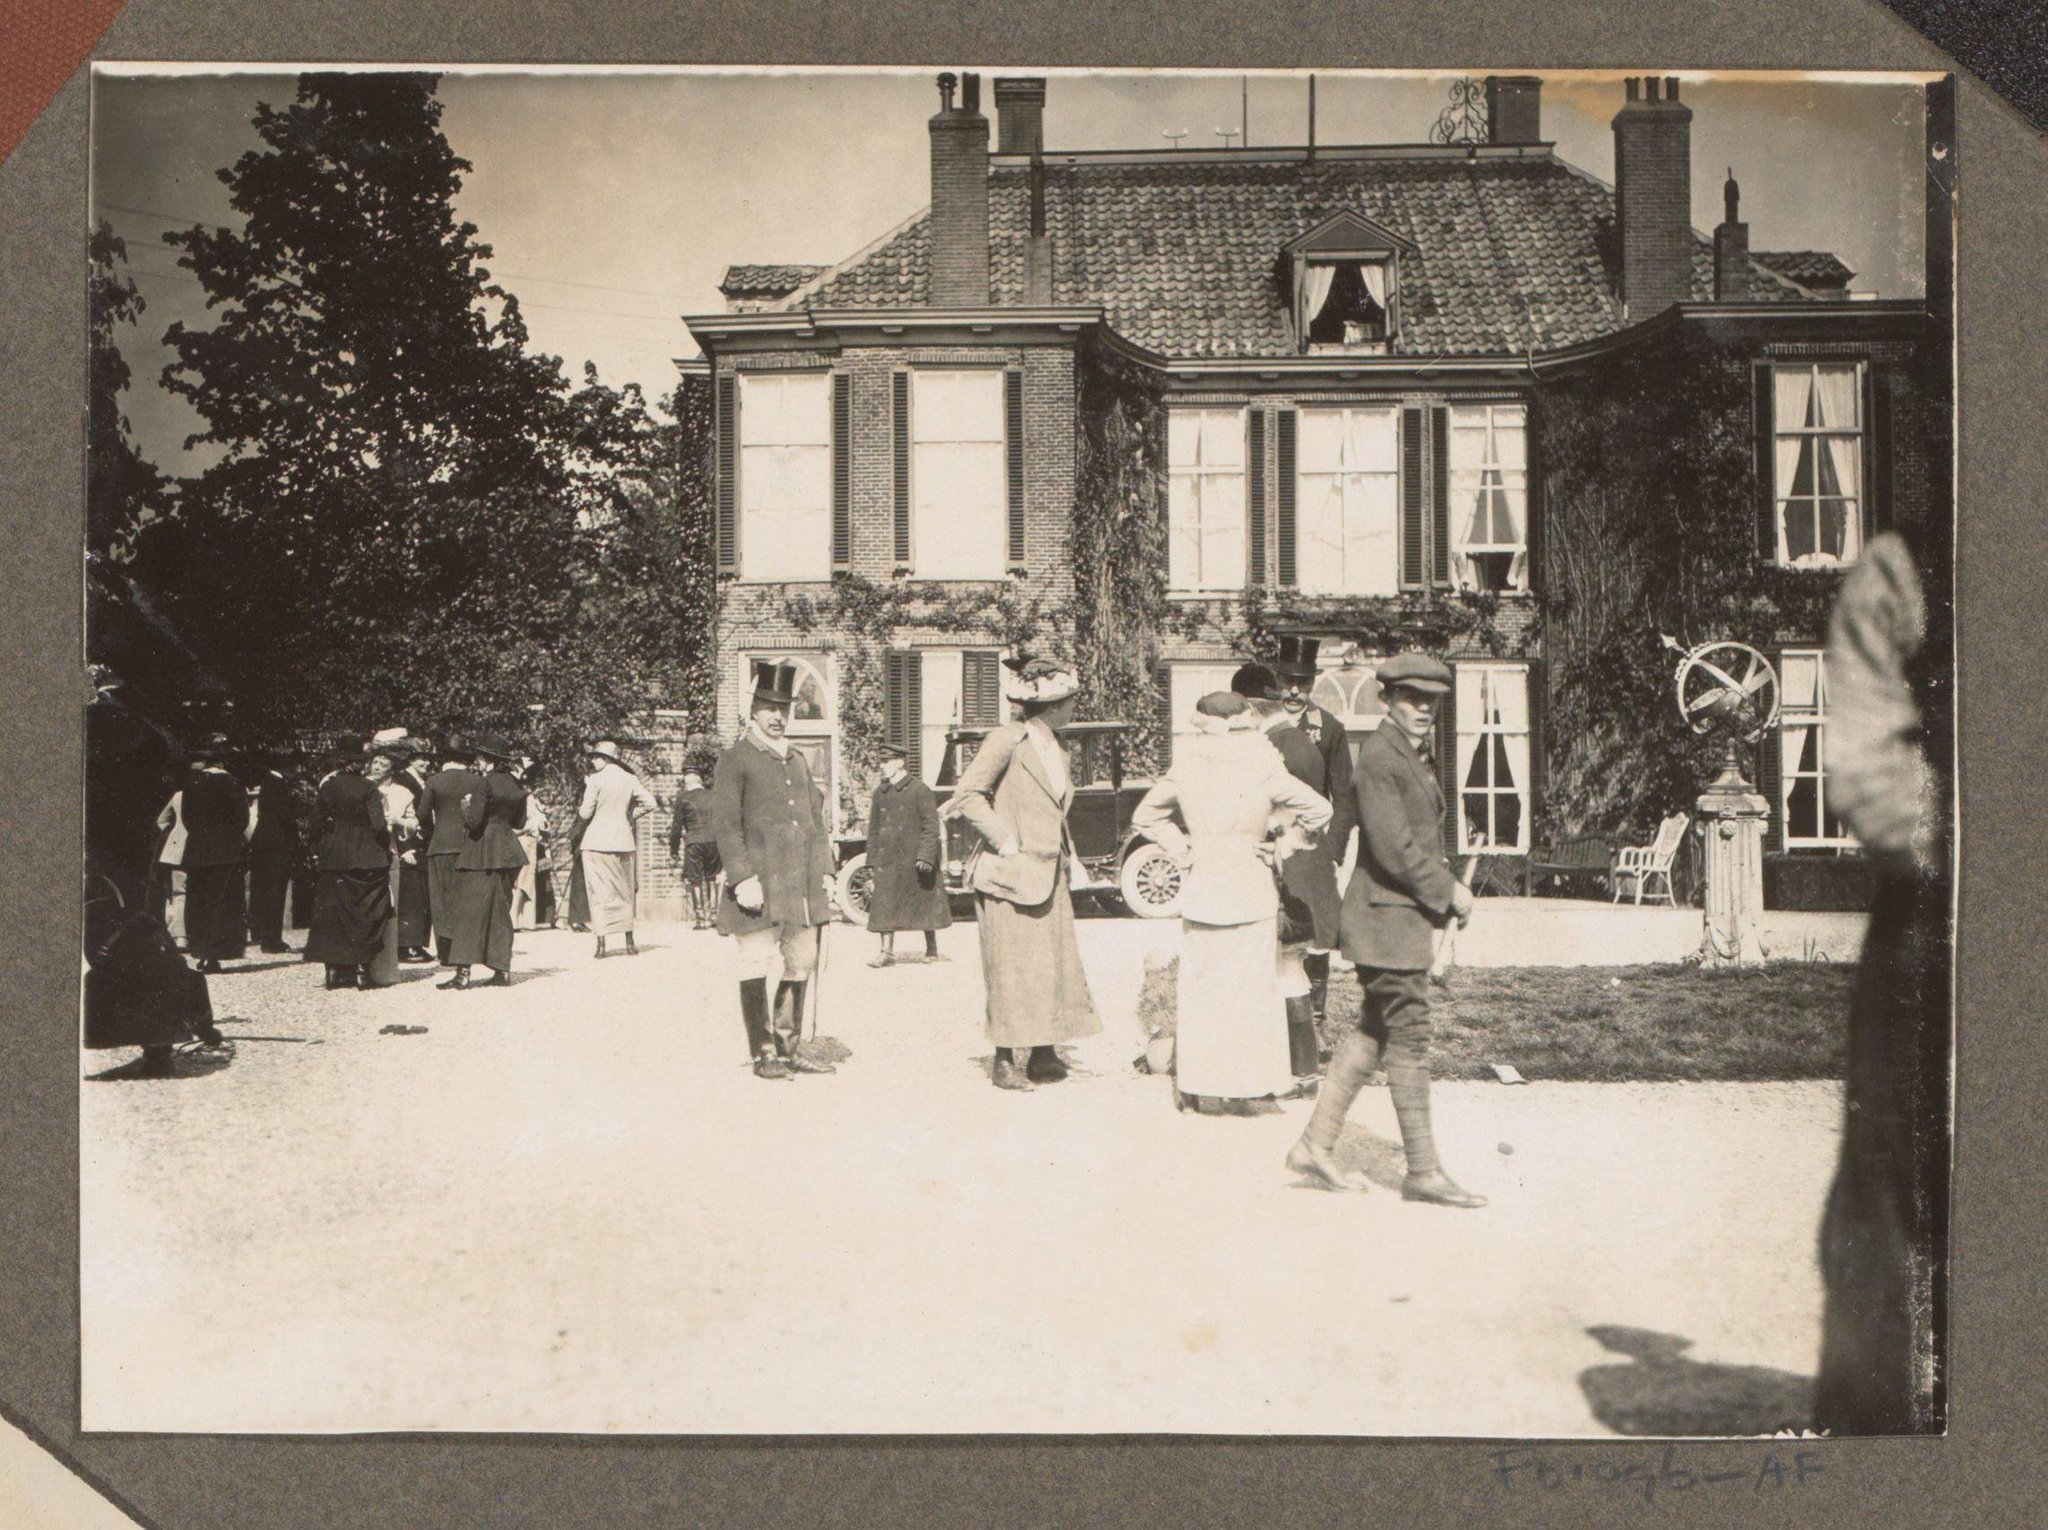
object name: photograph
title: Ruitertafereel op Koninklijke Houtvesterij Het Loo: gezelschap bij een landhuis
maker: Anonymous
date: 1900-1925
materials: photographic support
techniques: gelatin silver print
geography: het loo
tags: riding a horse, ass, or mule; rider, horseman, hunting, chase, hunting-ground, rural housing, e.g. country-house, villa, cottage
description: Onderdeel van Fotoalbum van de heer Brams, opperhoutvester van koningin Wilhelmina op Koninklijke Houtvesterij Het Loo.